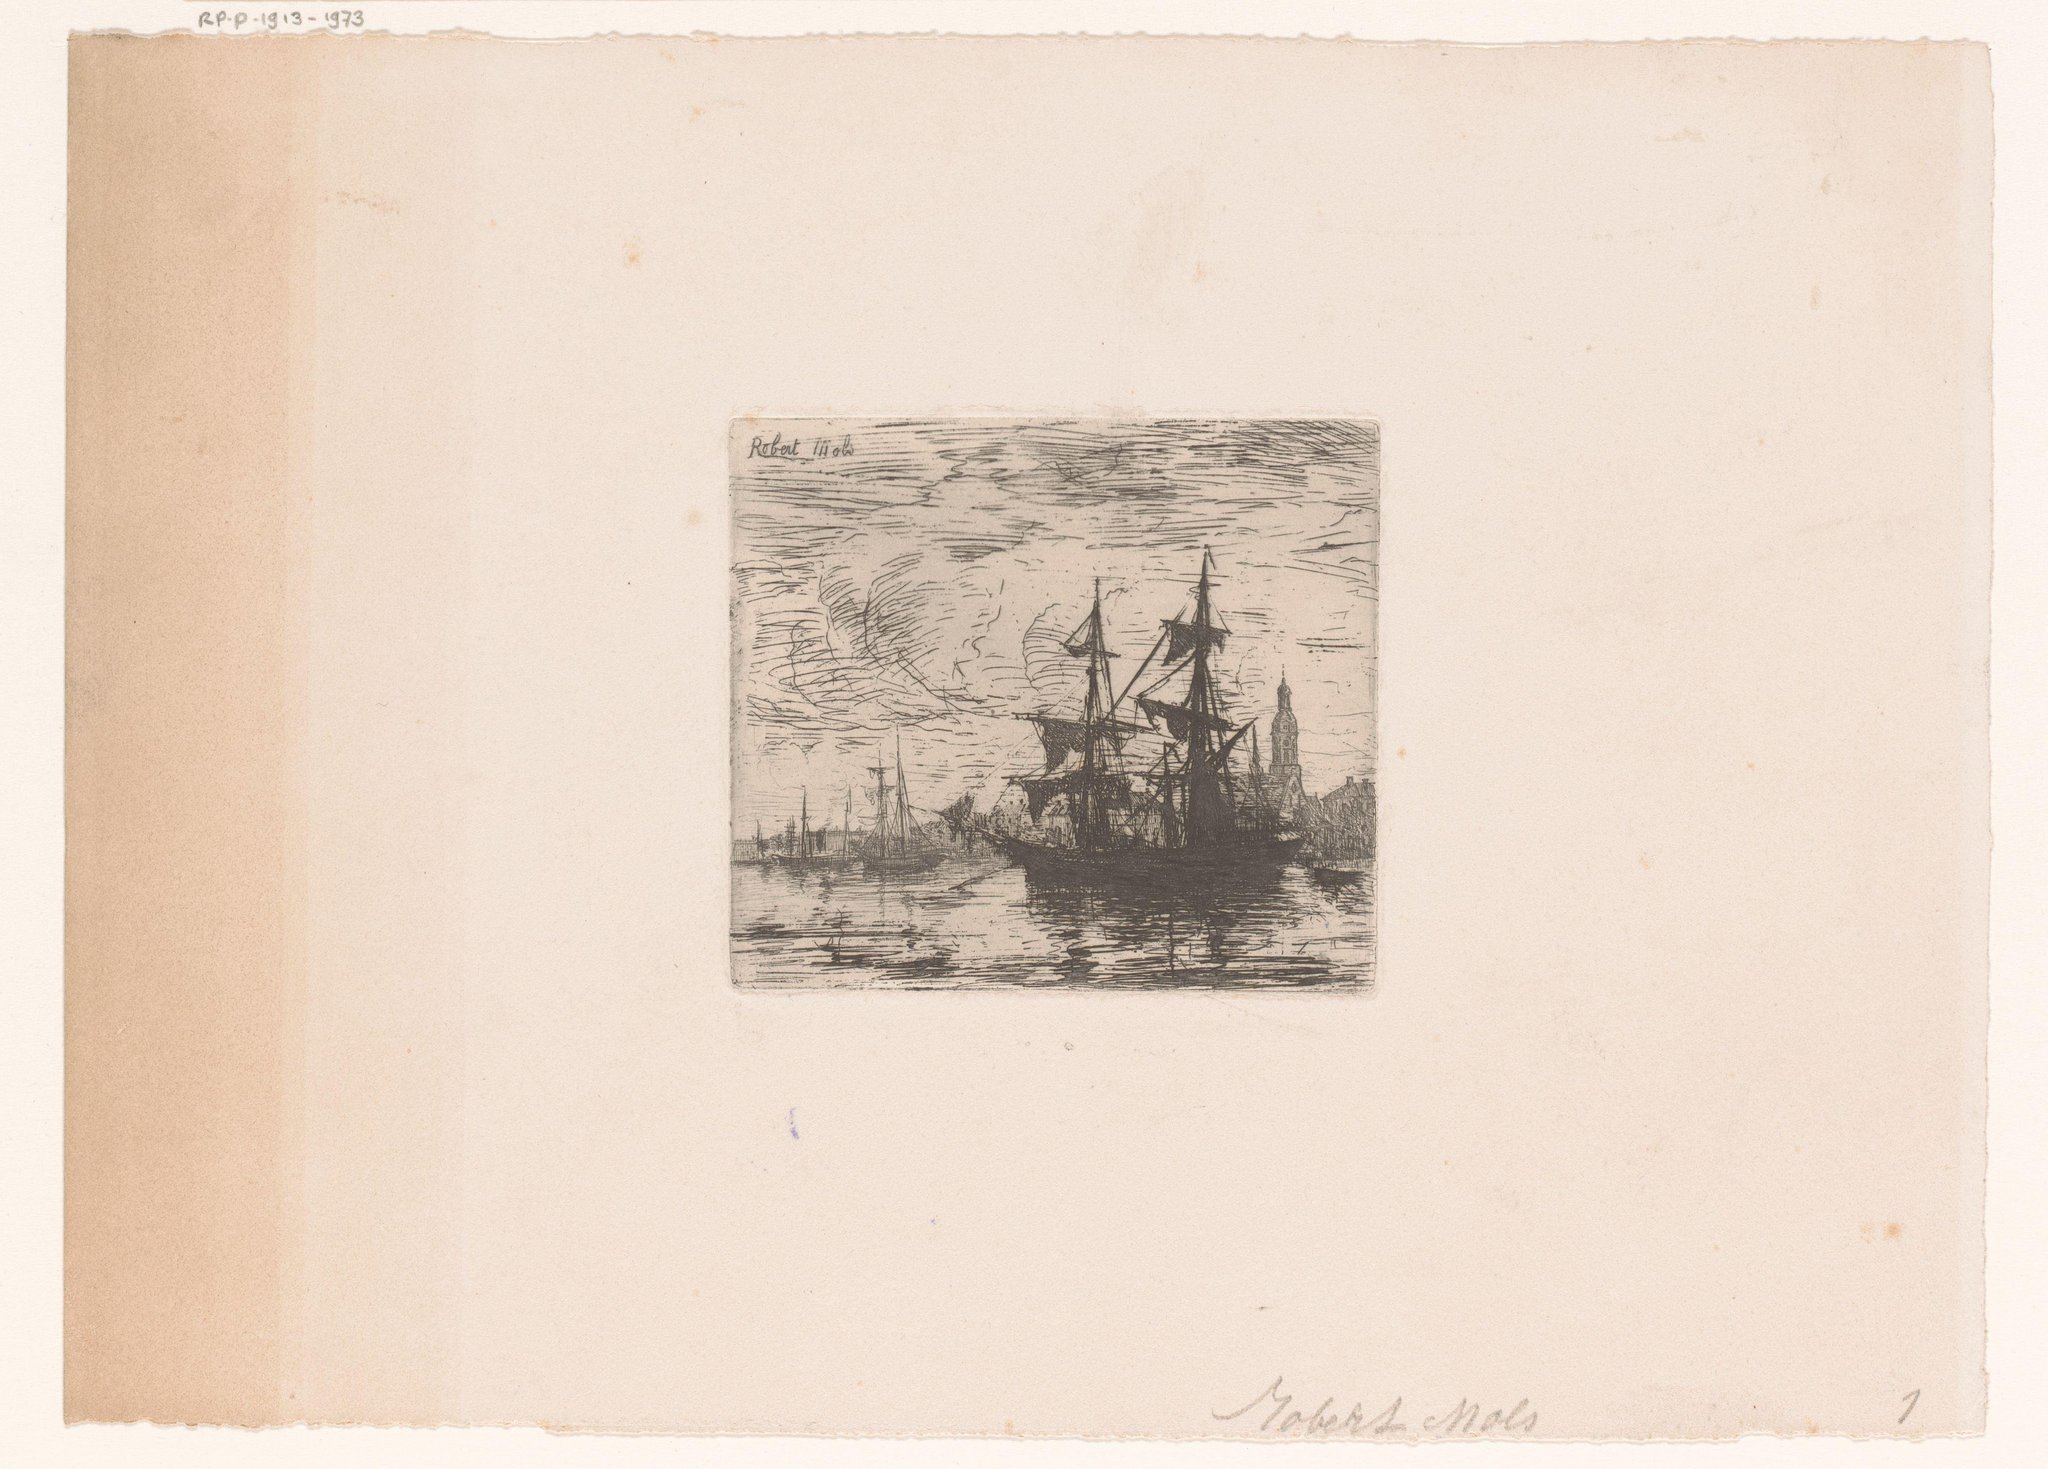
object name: print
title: Gezicht op de haven van Antwerpen met schepen op de voorgrond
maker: robert mols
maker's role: print maker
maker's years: 1848-1903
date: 1858-1903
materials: paper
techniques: etching, intaglio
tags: harbour, sailing-ship, sailing-boat, prospect of city, town panorama, silhouette of city, antwerp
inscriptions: collector's mark: Lugt 2228